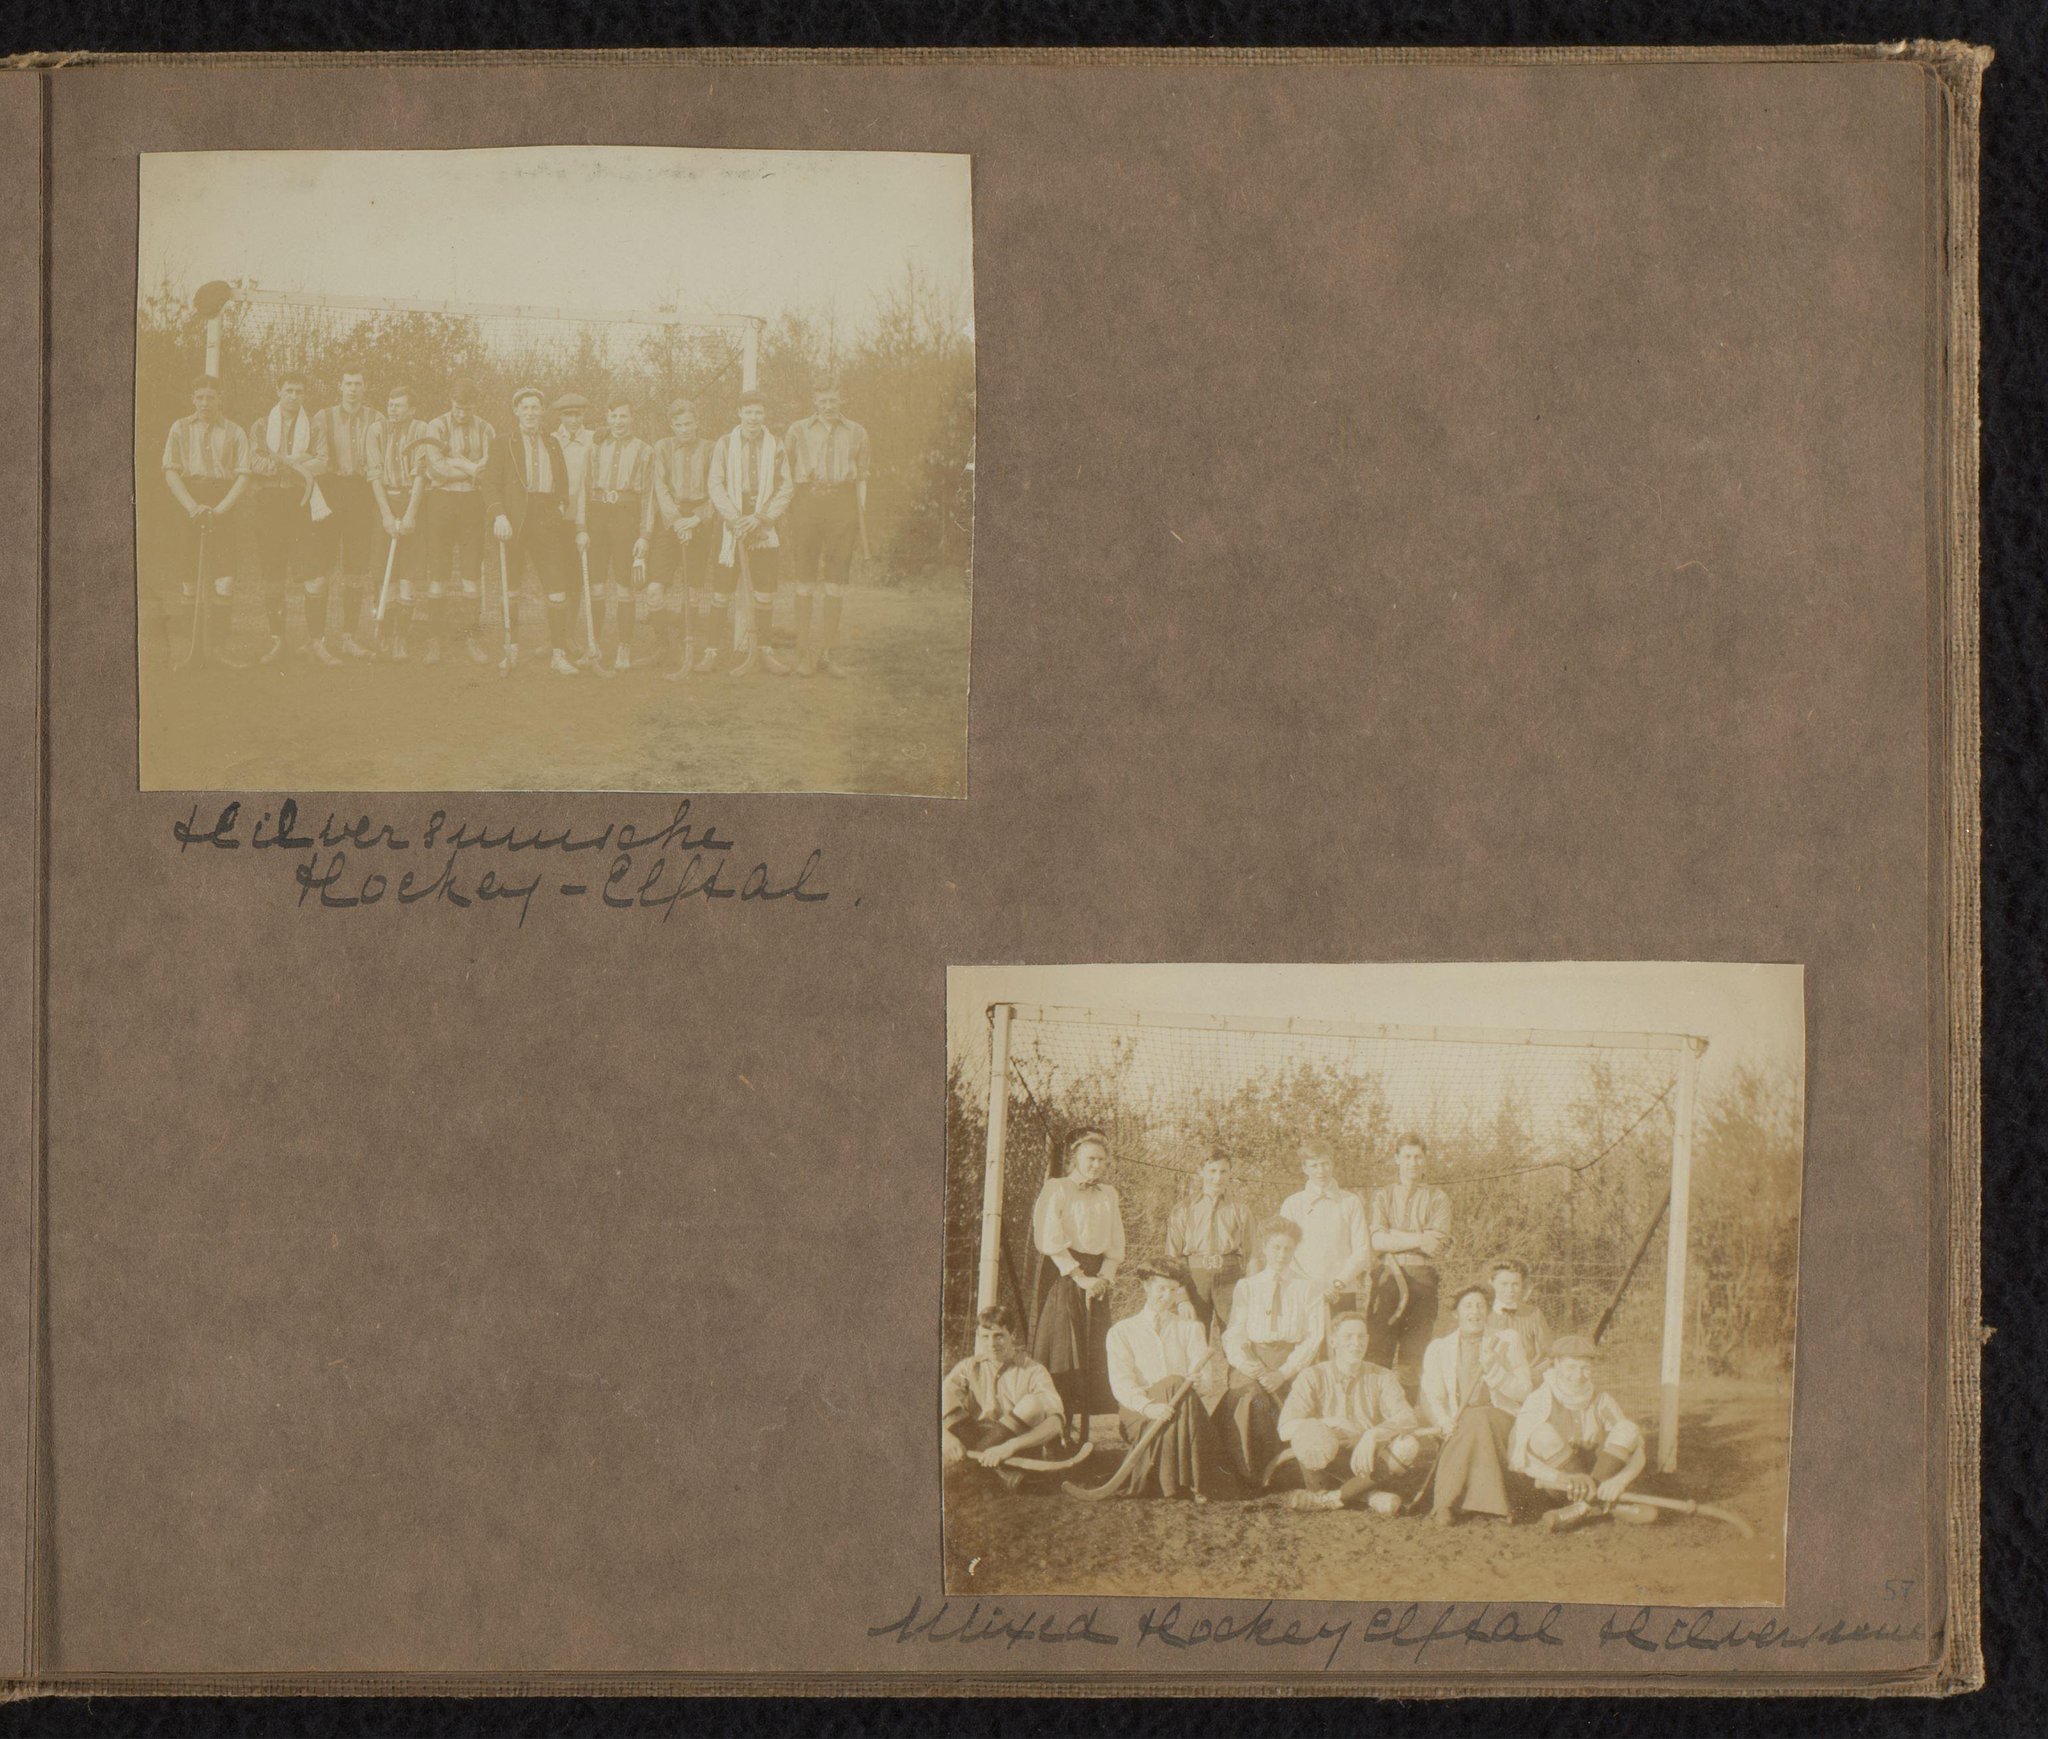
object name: album leaf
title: Twee groepsportretten van hockeyteams, Hilversum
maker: carolina frederika onnen (lien/loen)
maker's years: 1896-1983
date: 1910-1911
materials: paper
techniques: gelatin silver print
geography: hilversum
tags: hockey, historical persons not known by name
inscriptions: inscription: ‘Hilversumsche/ Hockey-Elftal.’, inscription: ‘Mixed Hockey Elftal Hilversum.’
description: Deze foto's maken deel uit van een album.